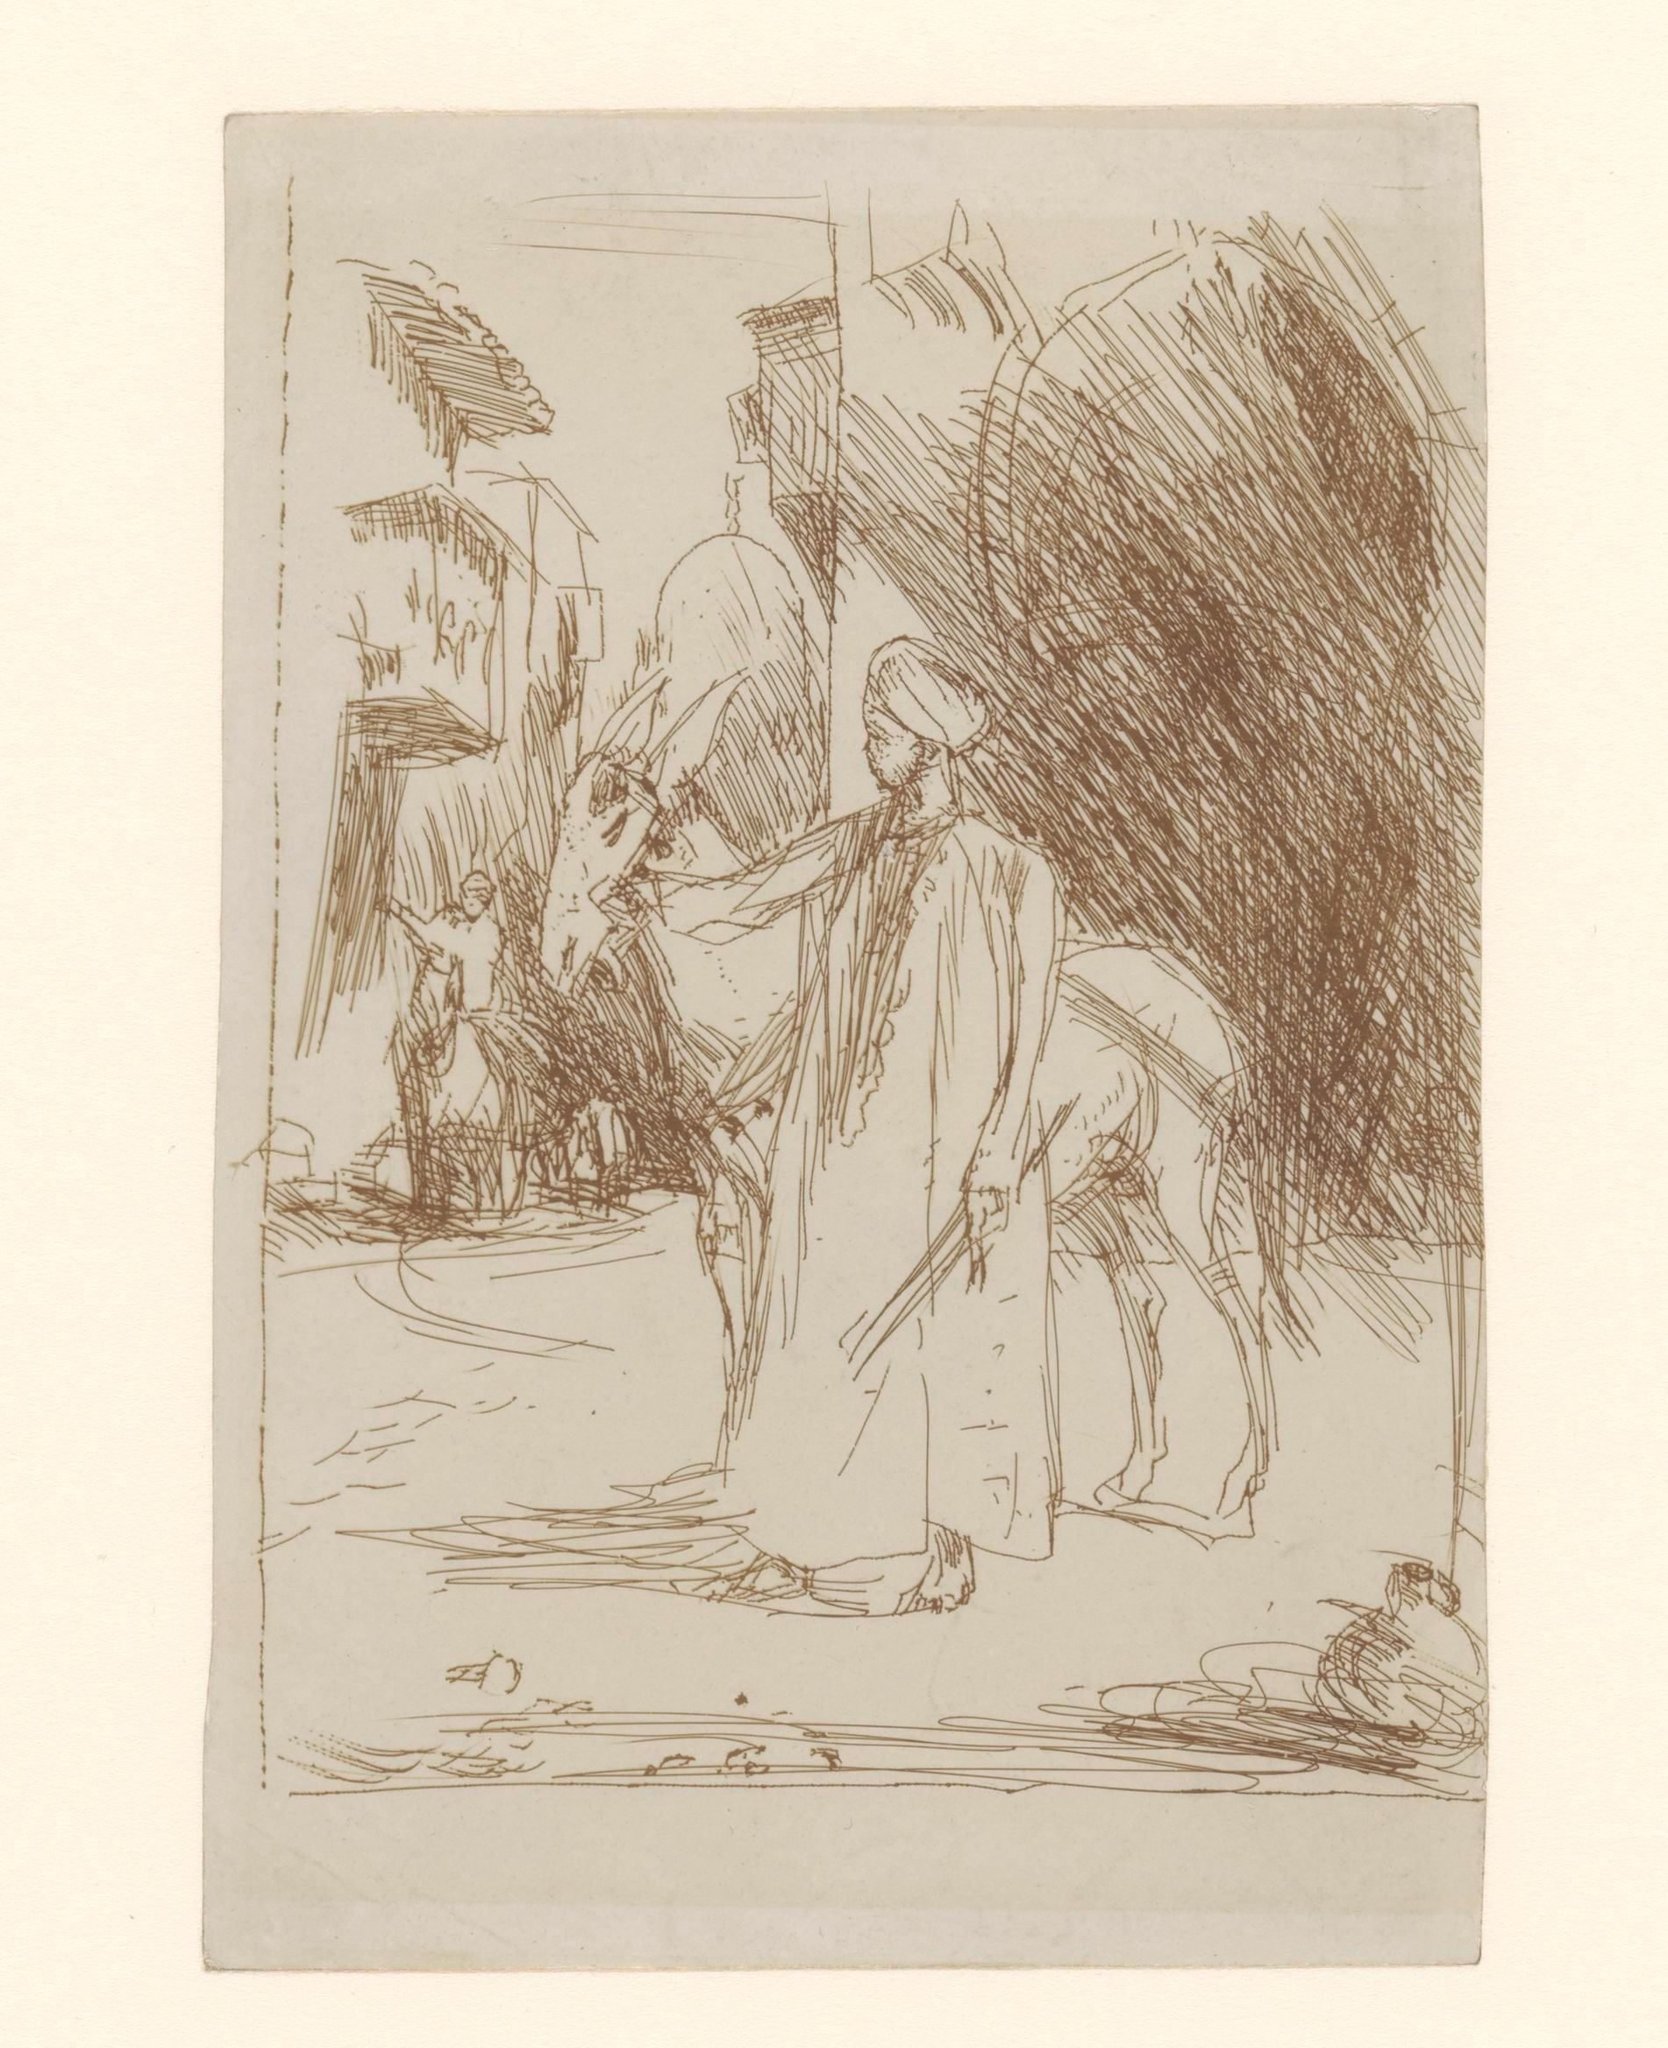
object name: print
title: Man met ezel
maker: marius bauer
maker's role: draughtsman, print maker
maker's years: 1867-1932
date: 1877-1932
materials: paper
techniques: cliché verre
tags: ass, donkey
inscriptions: collector's mark: Lugt 2228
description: Een man houdt op straat een ezel aan zijn tuig vast.